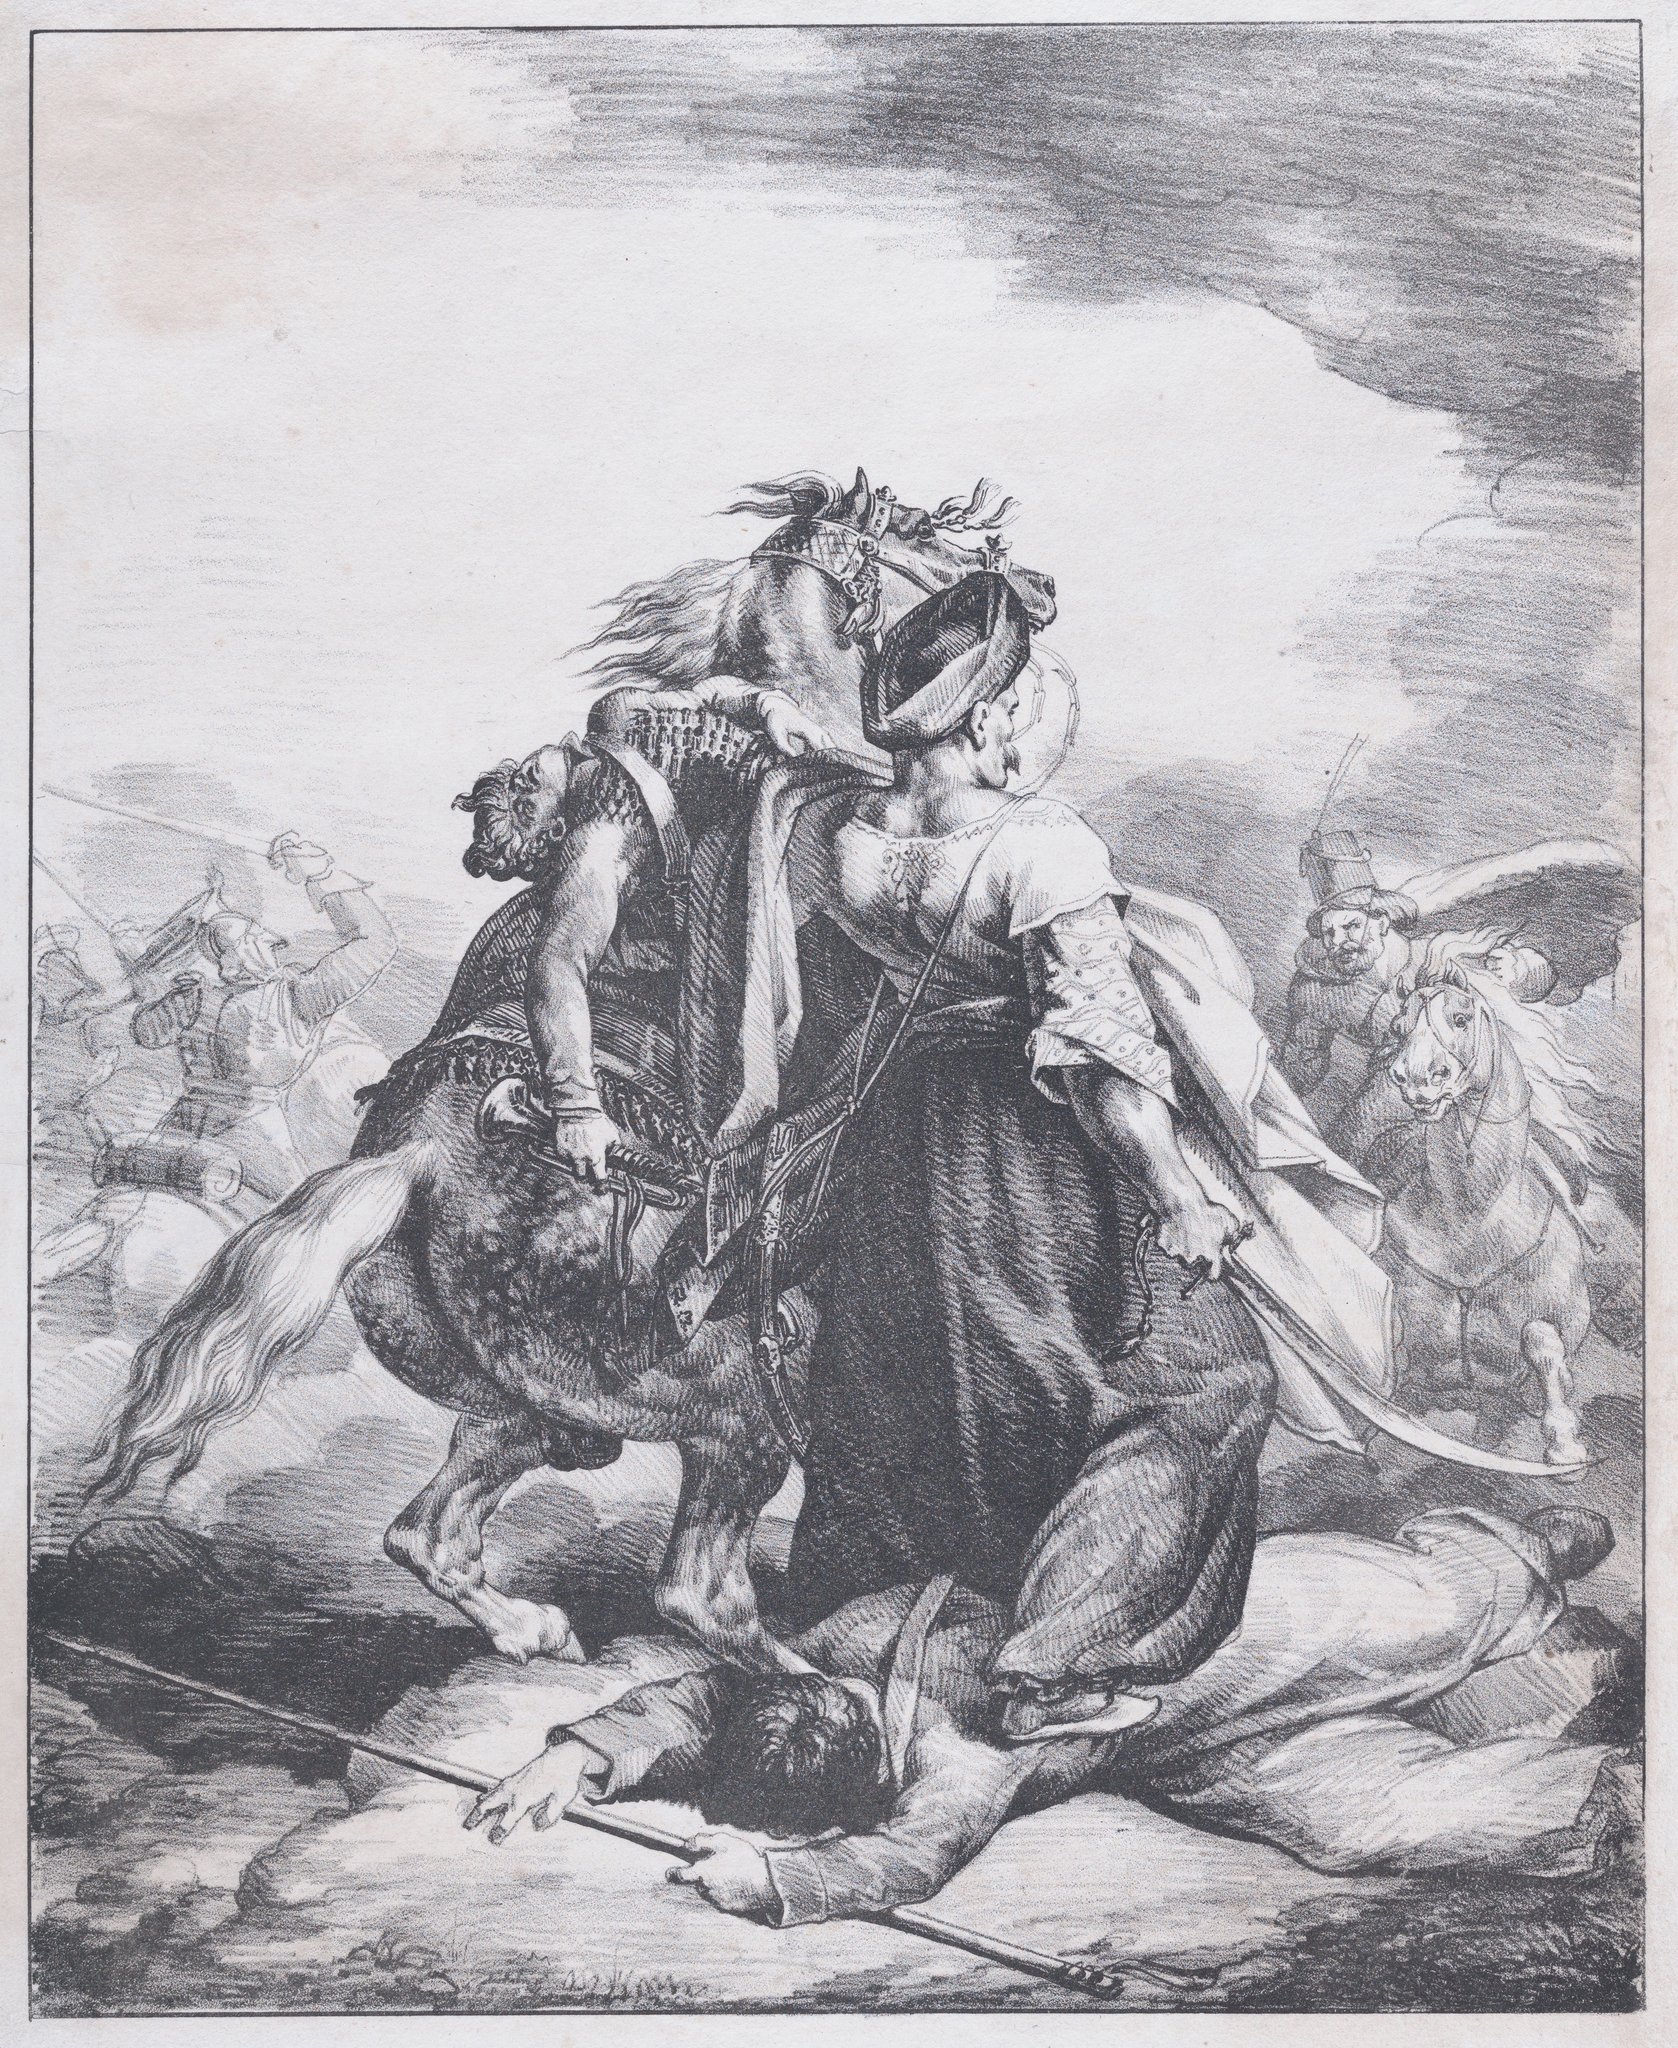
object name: print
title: Mamluk Defending a Wounded Trumpeter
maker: jean louis andré théodore géricault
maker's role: artist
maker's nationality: french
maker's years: 1791-1824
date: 1818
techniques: lithograph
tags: battles,swords,men,horses